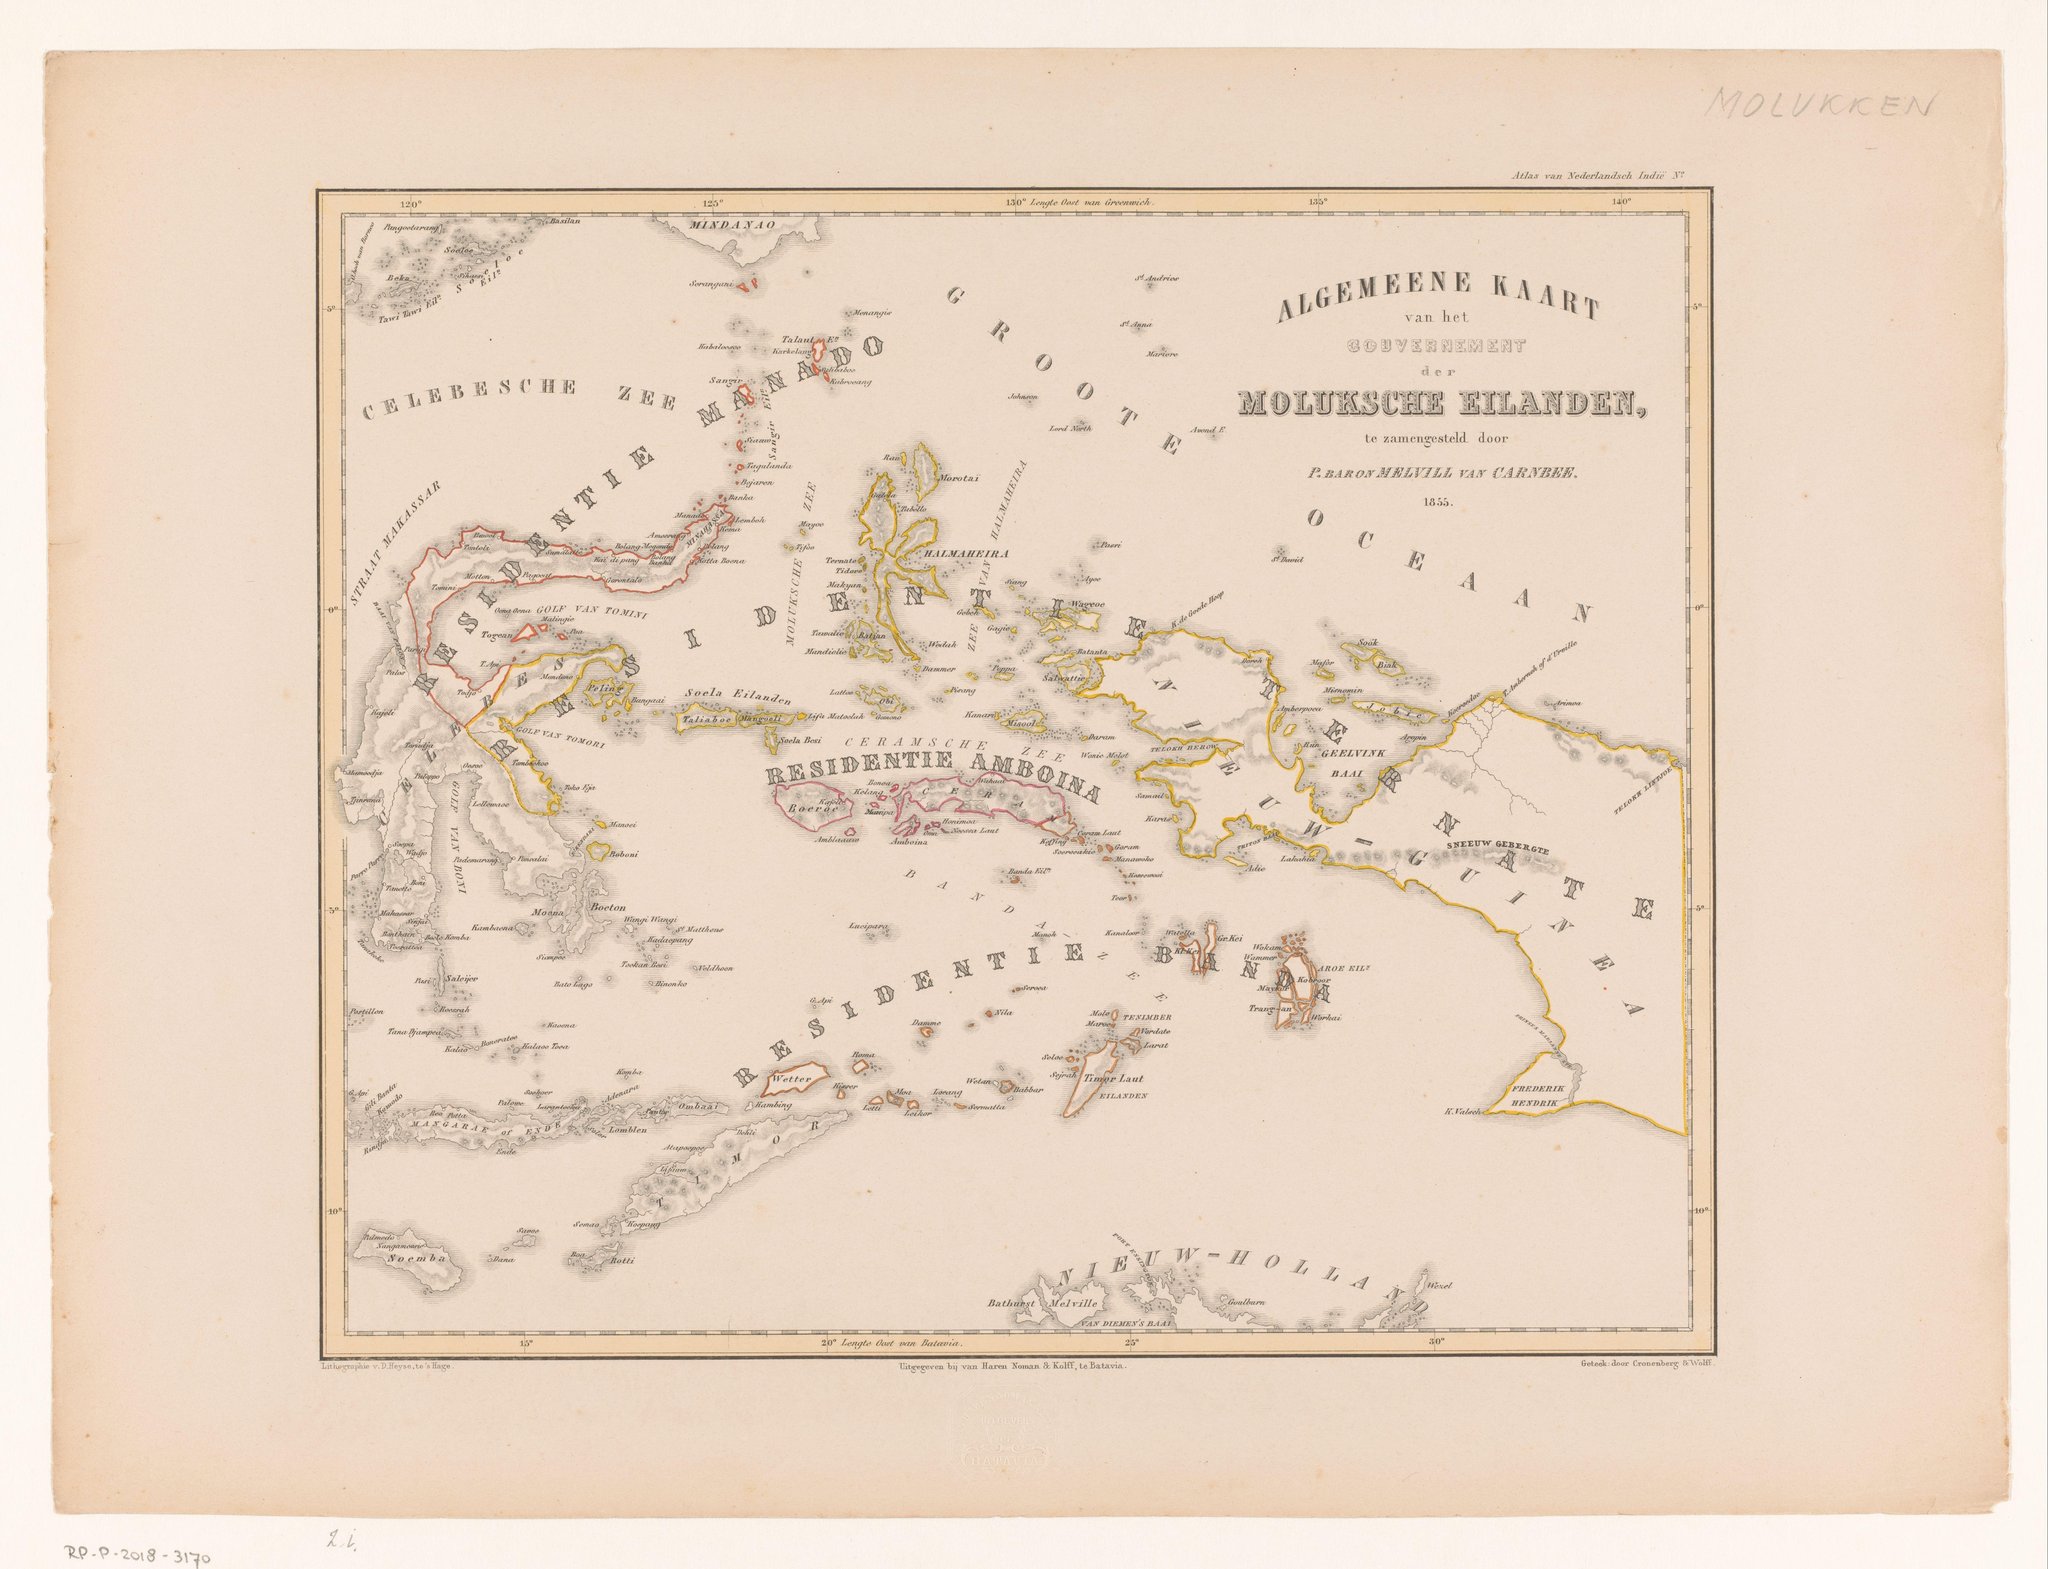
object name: print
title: Kaart van de Molukken, Celebes, Timor en het westelijke deel van het eiland Nieuw-Guinea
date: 1855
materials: paper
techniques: hand coloring, lithograph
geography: batavia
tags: marine charts, island (in tropical and sub-tropical regions)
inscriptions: collector's mark: Lugt 2228, check stamp: ‘Van Haren Noman & Kolff uitgevers te Batavia’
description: Prent uit: Melvill van Carnbee, Pieter baron & Versteeg, W.F. Algemeene Atlas van Nederlandsch-Indië (...). Batavia: Van Haren Noman & Kolff, 1853-1862. Dl.2, krt. 18.